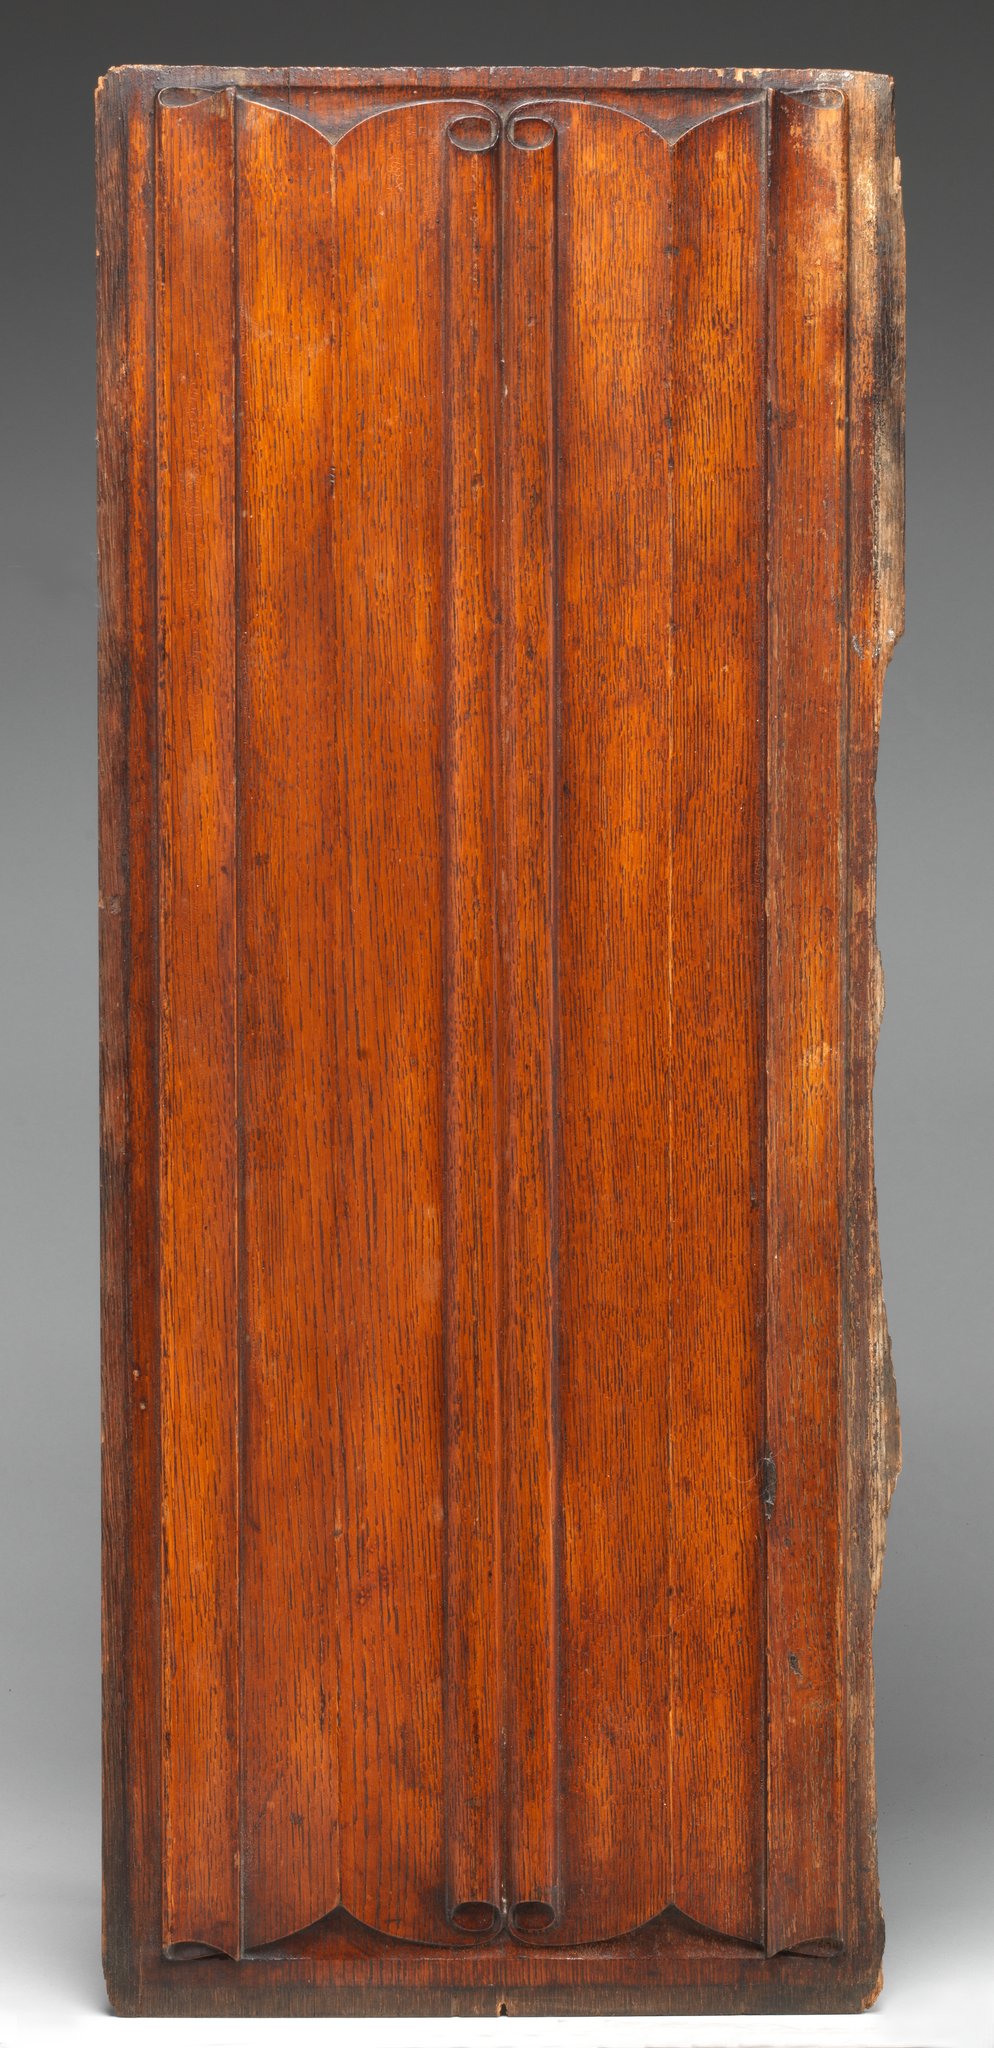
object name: panel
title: Panel from the Palace of Westminster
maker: augustus welby northmore pugin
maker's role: designer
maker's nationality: british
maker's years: 1812-1852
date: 1847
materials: wood